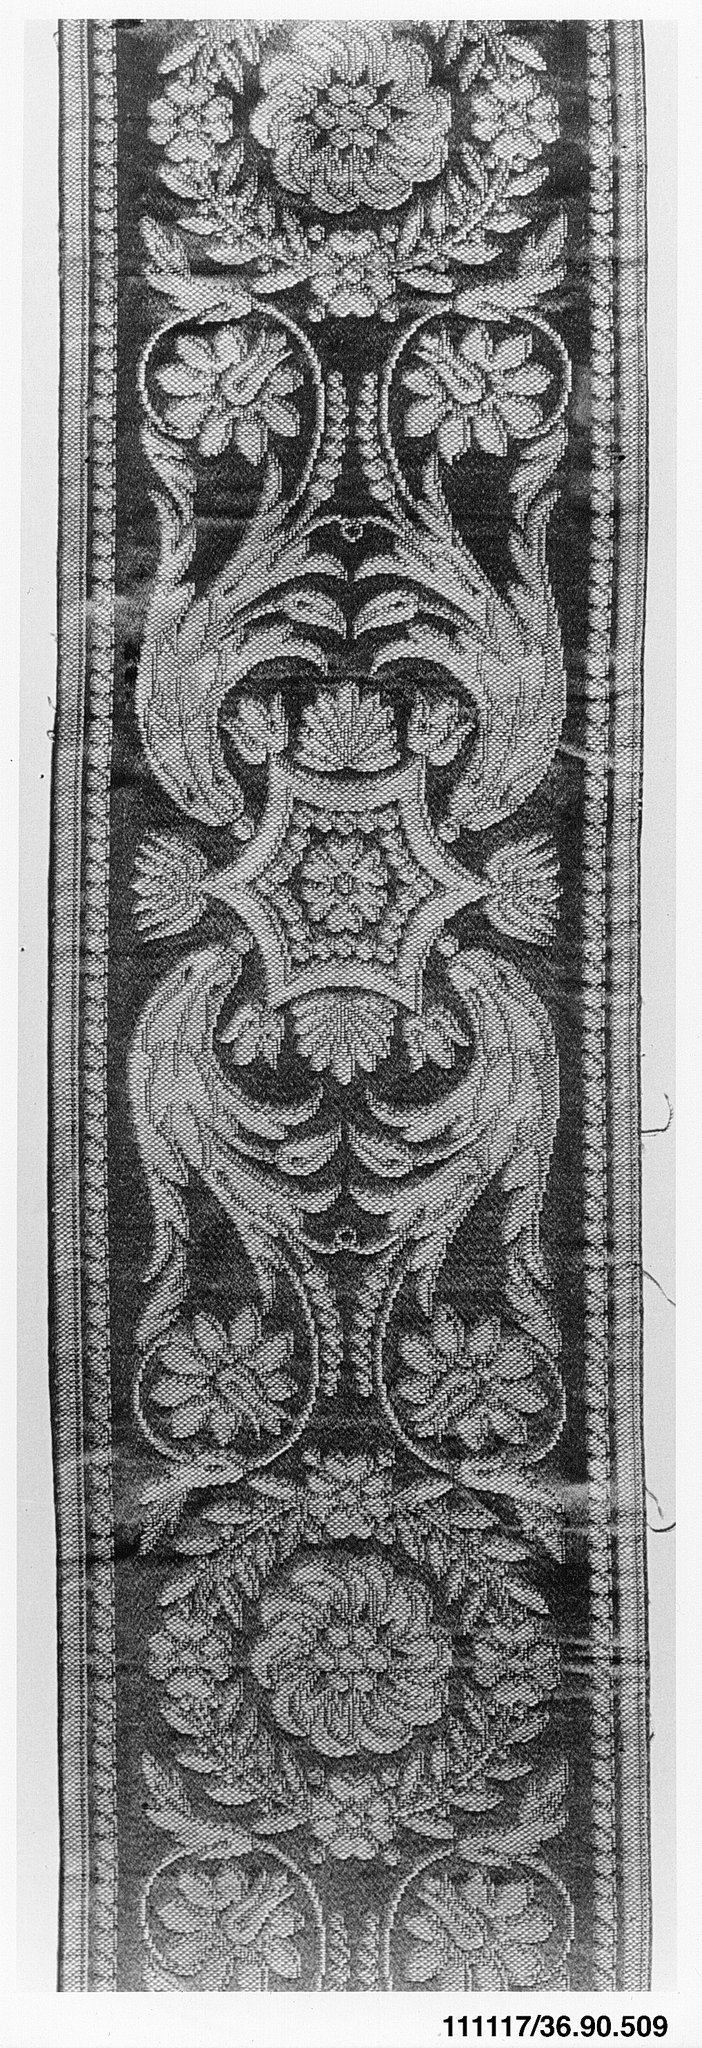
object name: piece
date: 1801-1833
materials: silk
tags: flowers